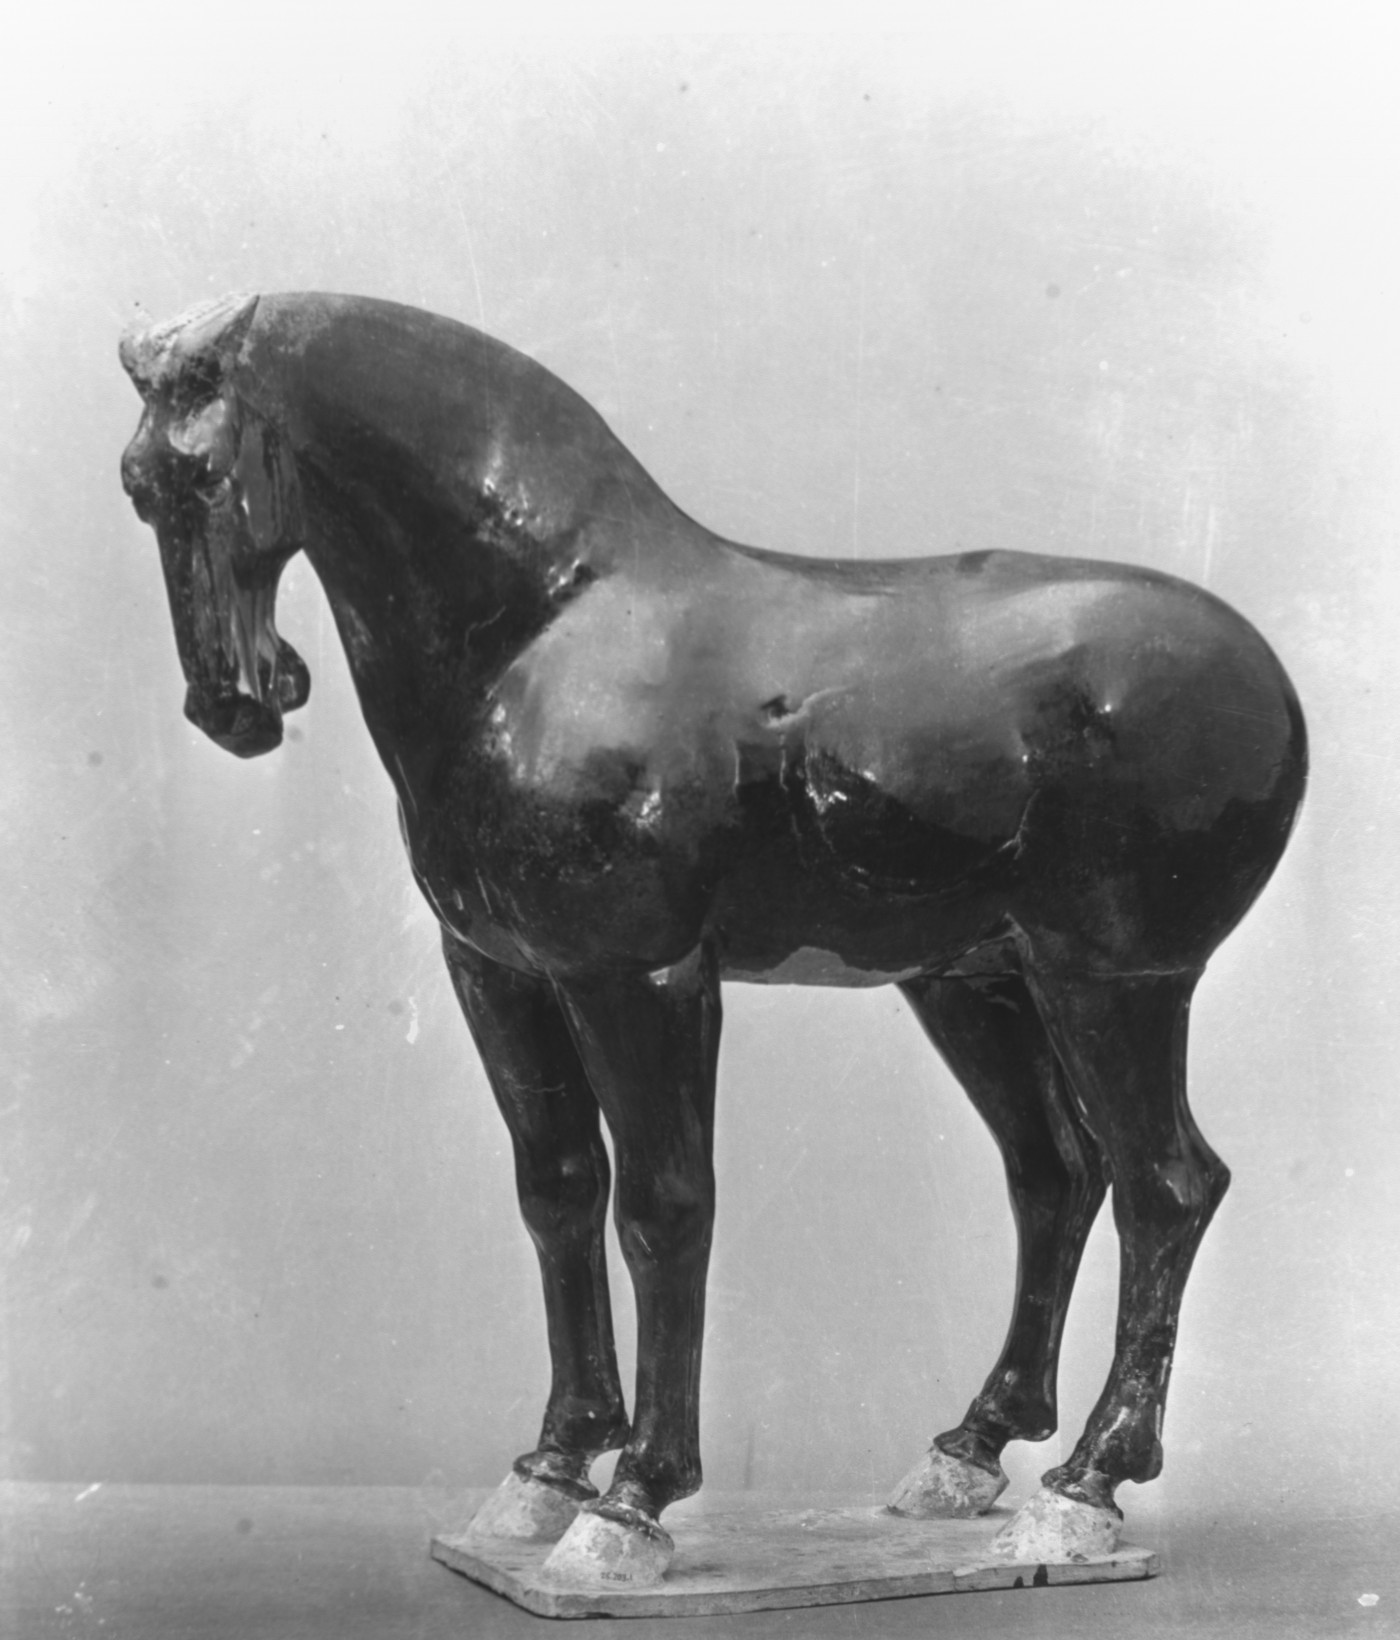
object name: figure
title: Horse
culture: chinese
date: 601-800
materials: earthenware, glaze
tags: horses